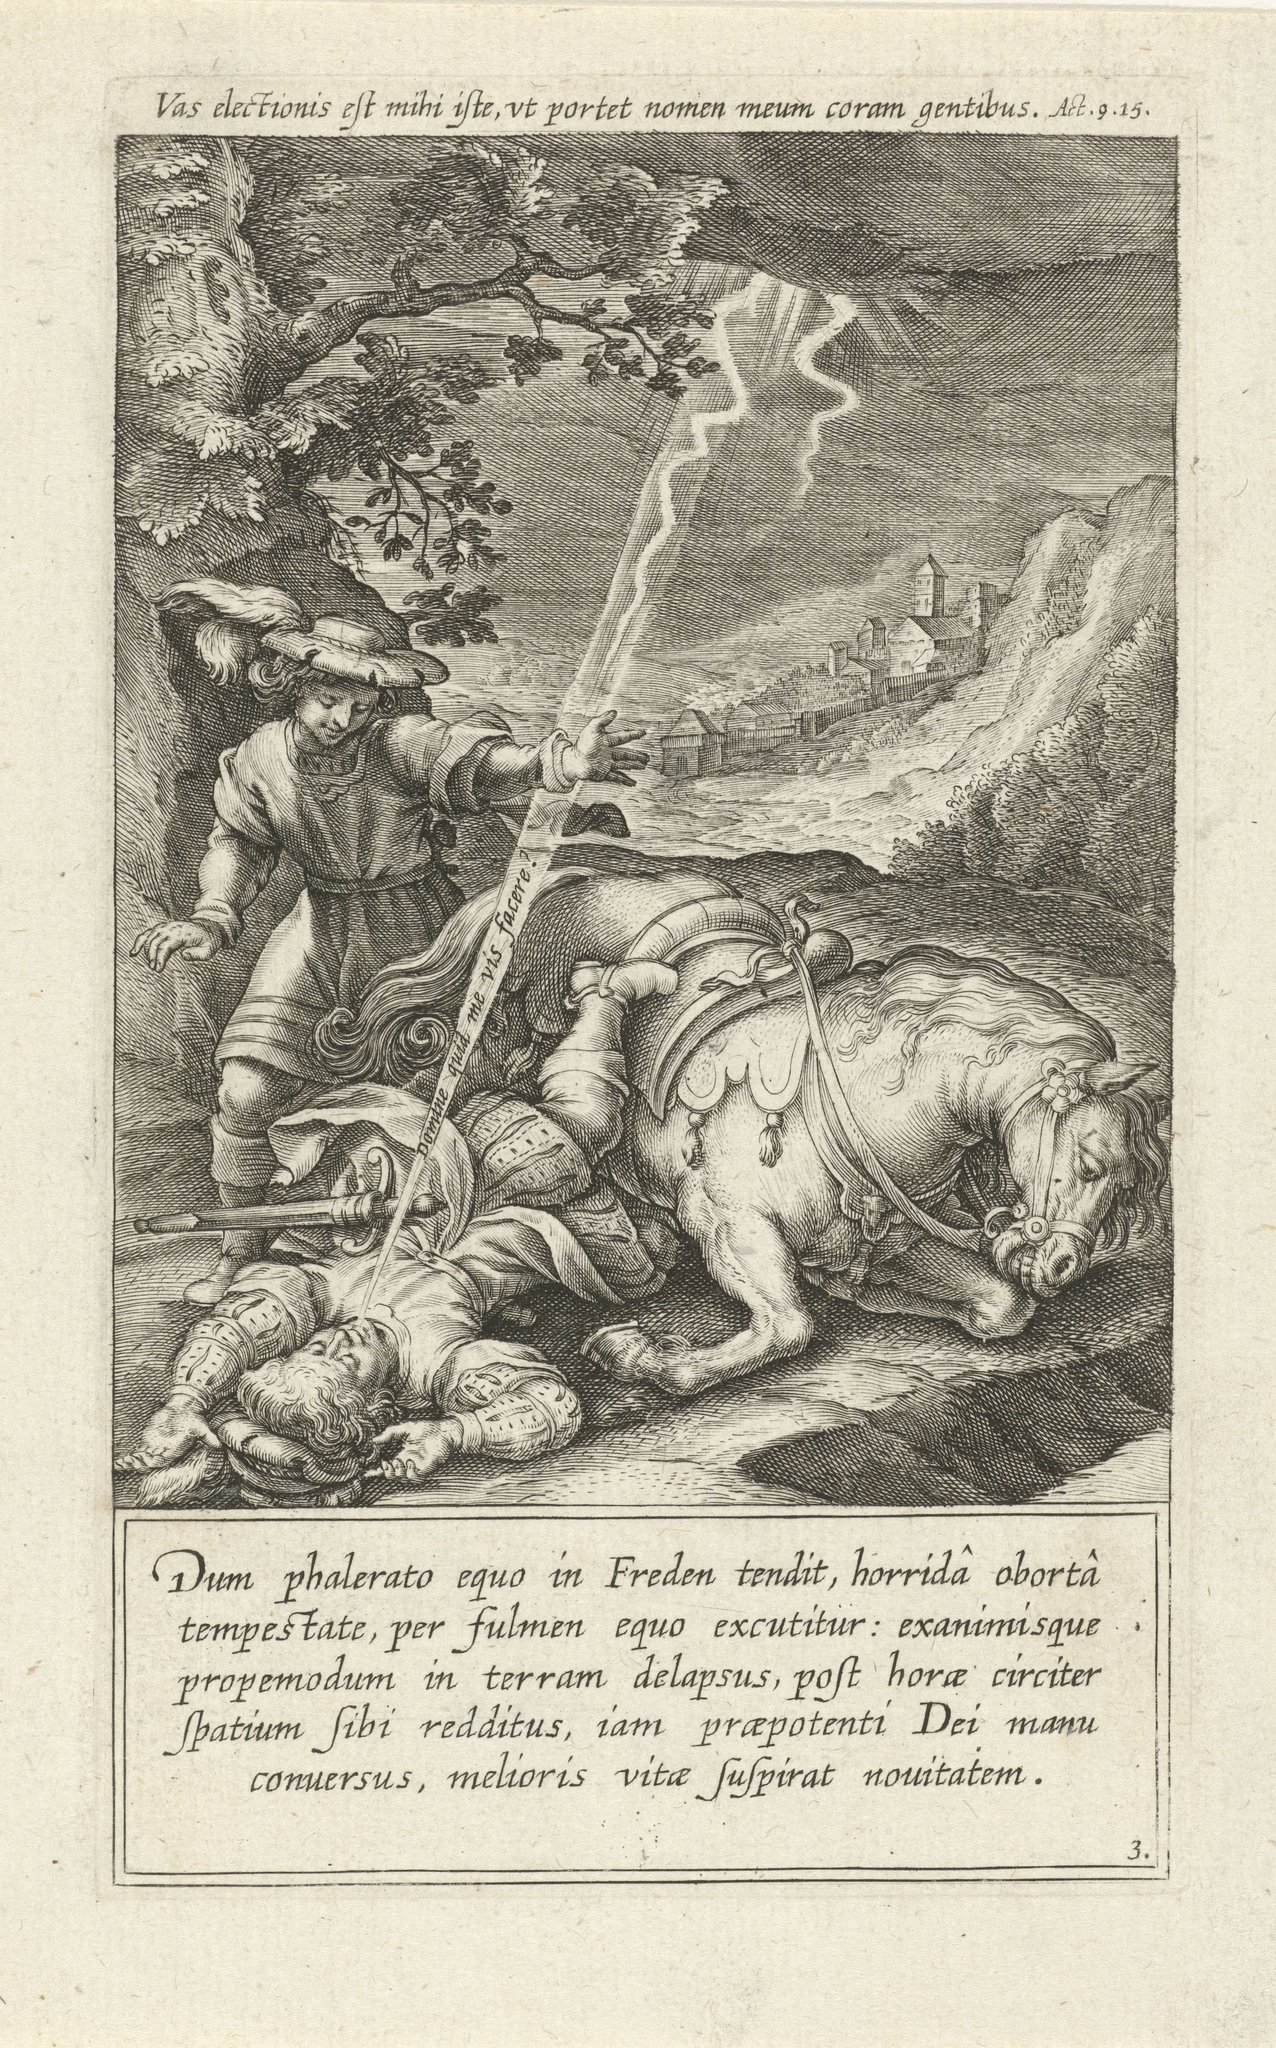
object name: print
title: De heilige Norbertus wordt door bliksem getroffen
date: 1622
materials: paper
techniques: engraving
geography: antwerp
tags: the conversion of st. norbert: when riding on horseback, he is thrown out of the saddle by a thunderbolt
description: Tijdens een rit slaat de bliksem in vlak voor het paard van de heilige Norbertus. Hij valt van zijn paard en hoort God die hem vermanend toespreekt en hem tot inkeer brengt. De prent heeft twee Latijnse opschriften: een boven en een onder de voorstelling.